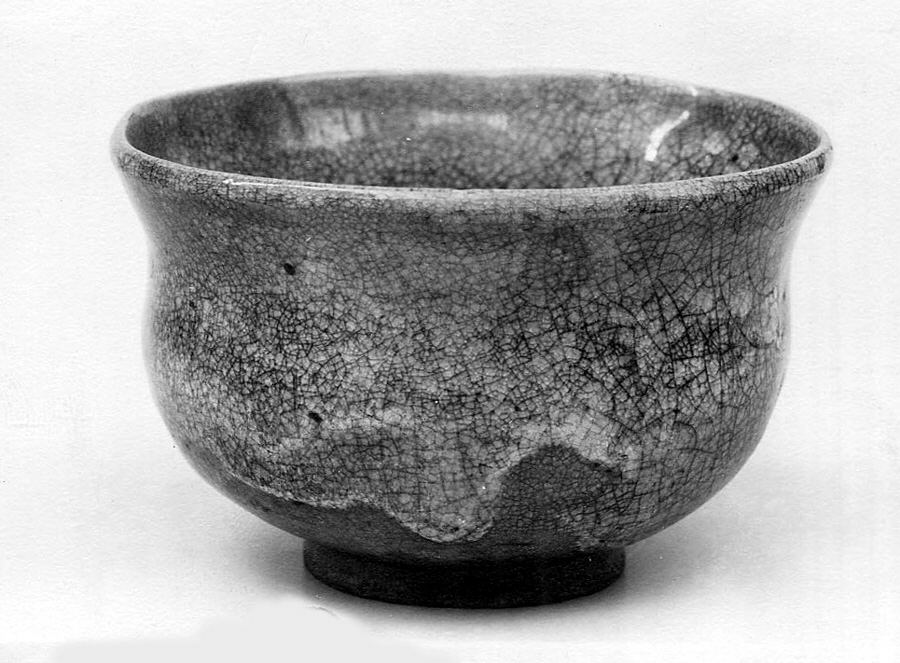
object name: teabowl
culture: japanese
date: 1750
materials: clay, glaze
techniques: overglaze